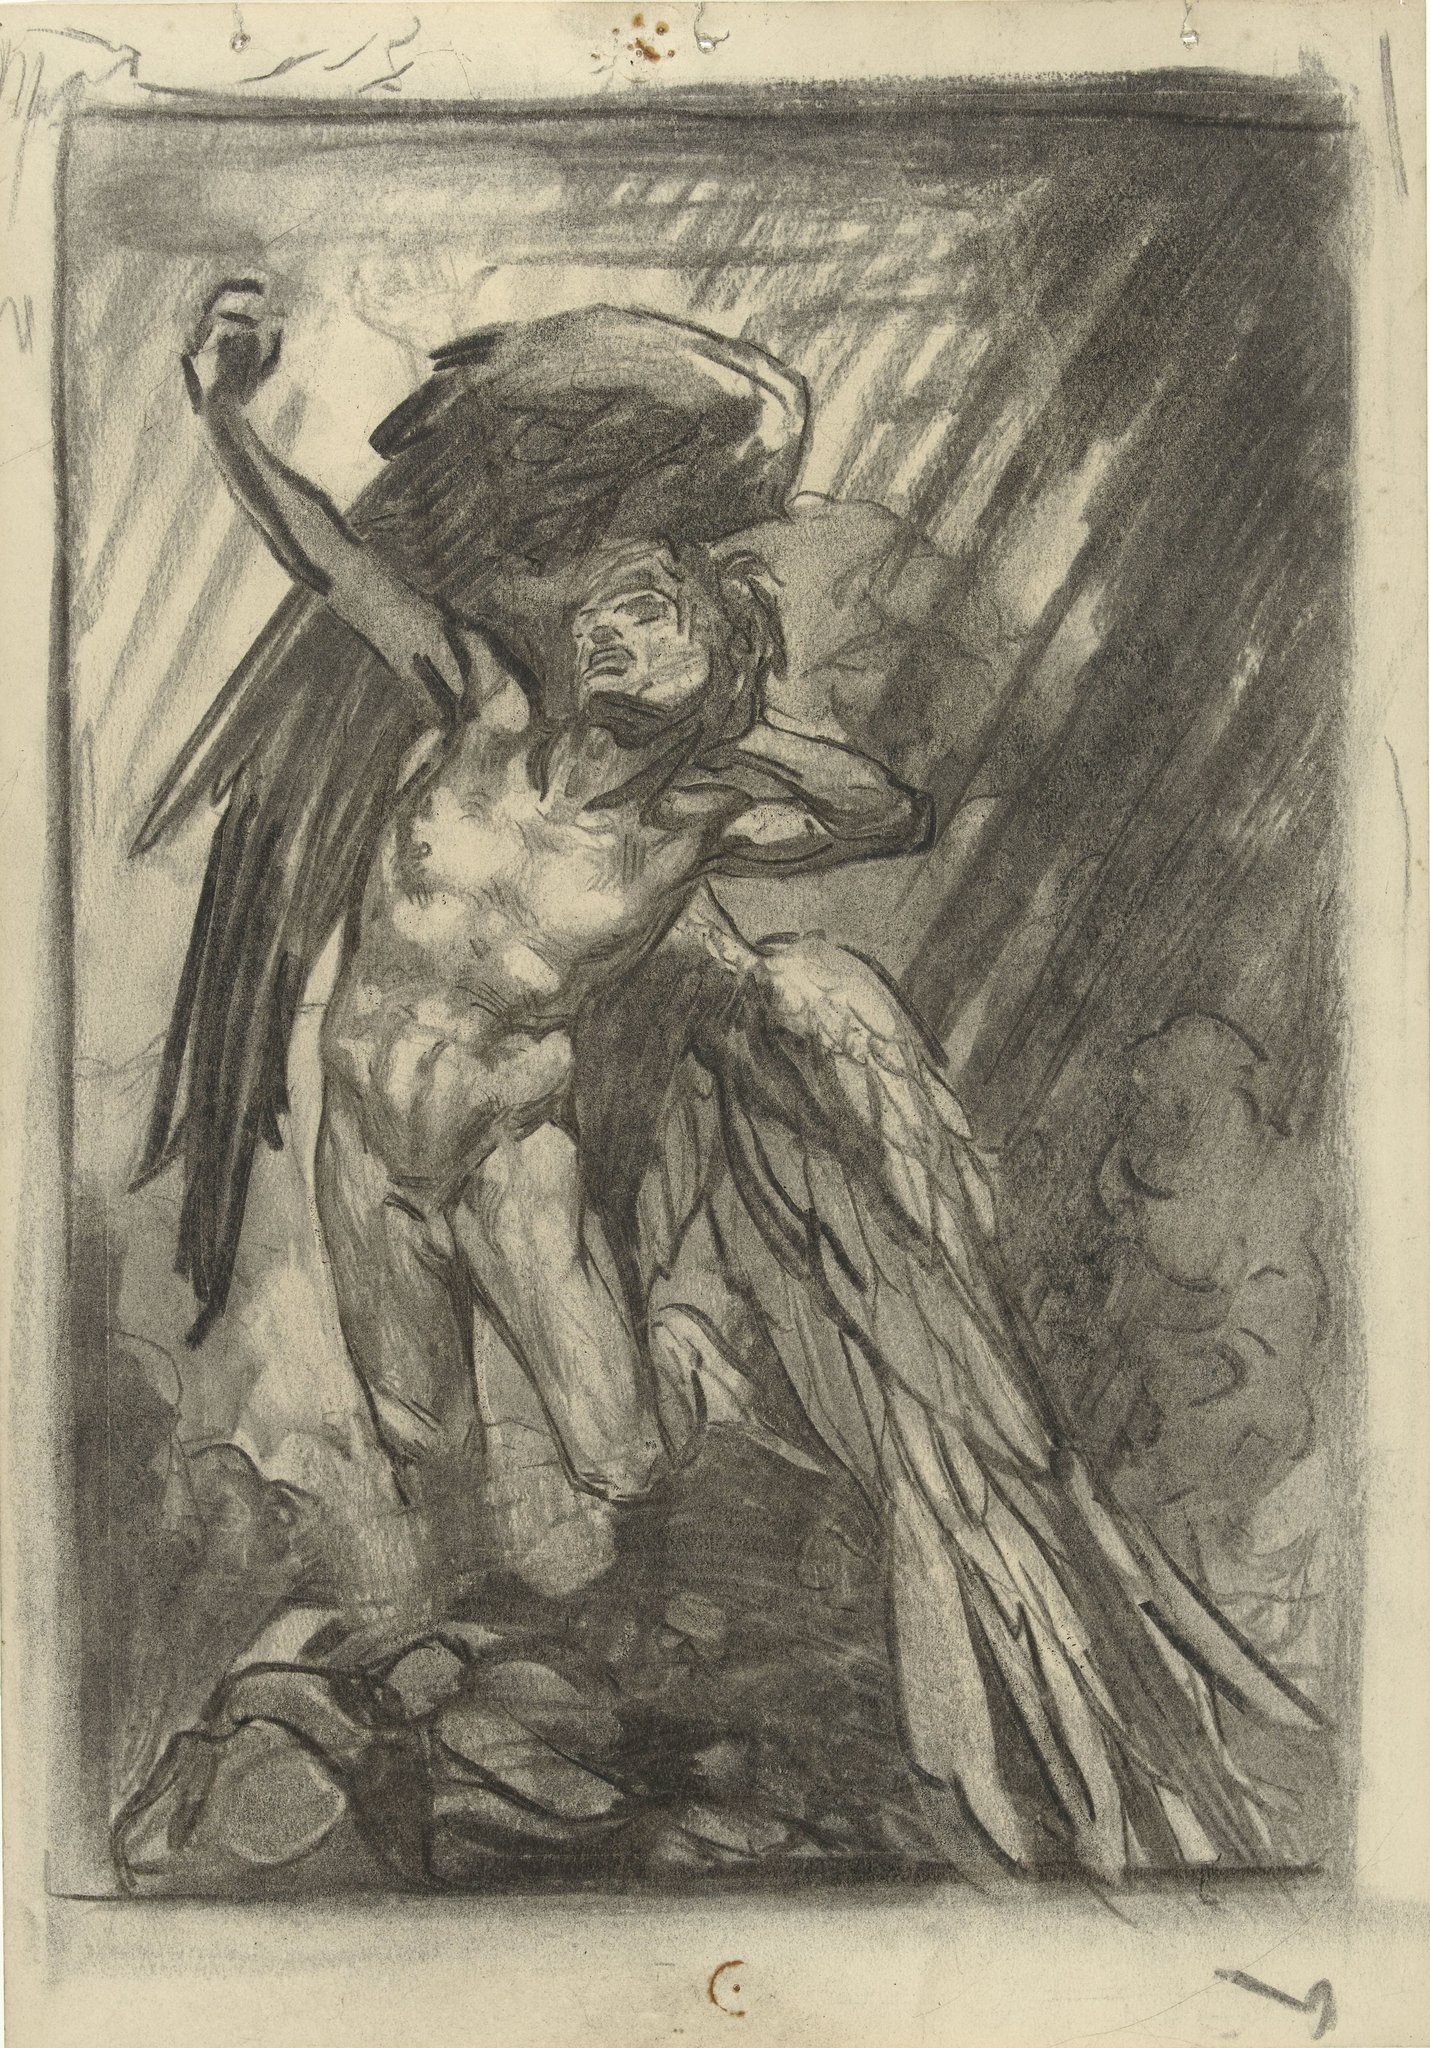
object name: design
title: Prometheus, roepend vanuit een rotslandschap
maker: johannes josephus aarts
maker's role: draughtsman, print maker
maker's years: 1871-1934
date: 1881-1934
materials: charcoal, paper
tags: an eagle tears at prometheus' liver